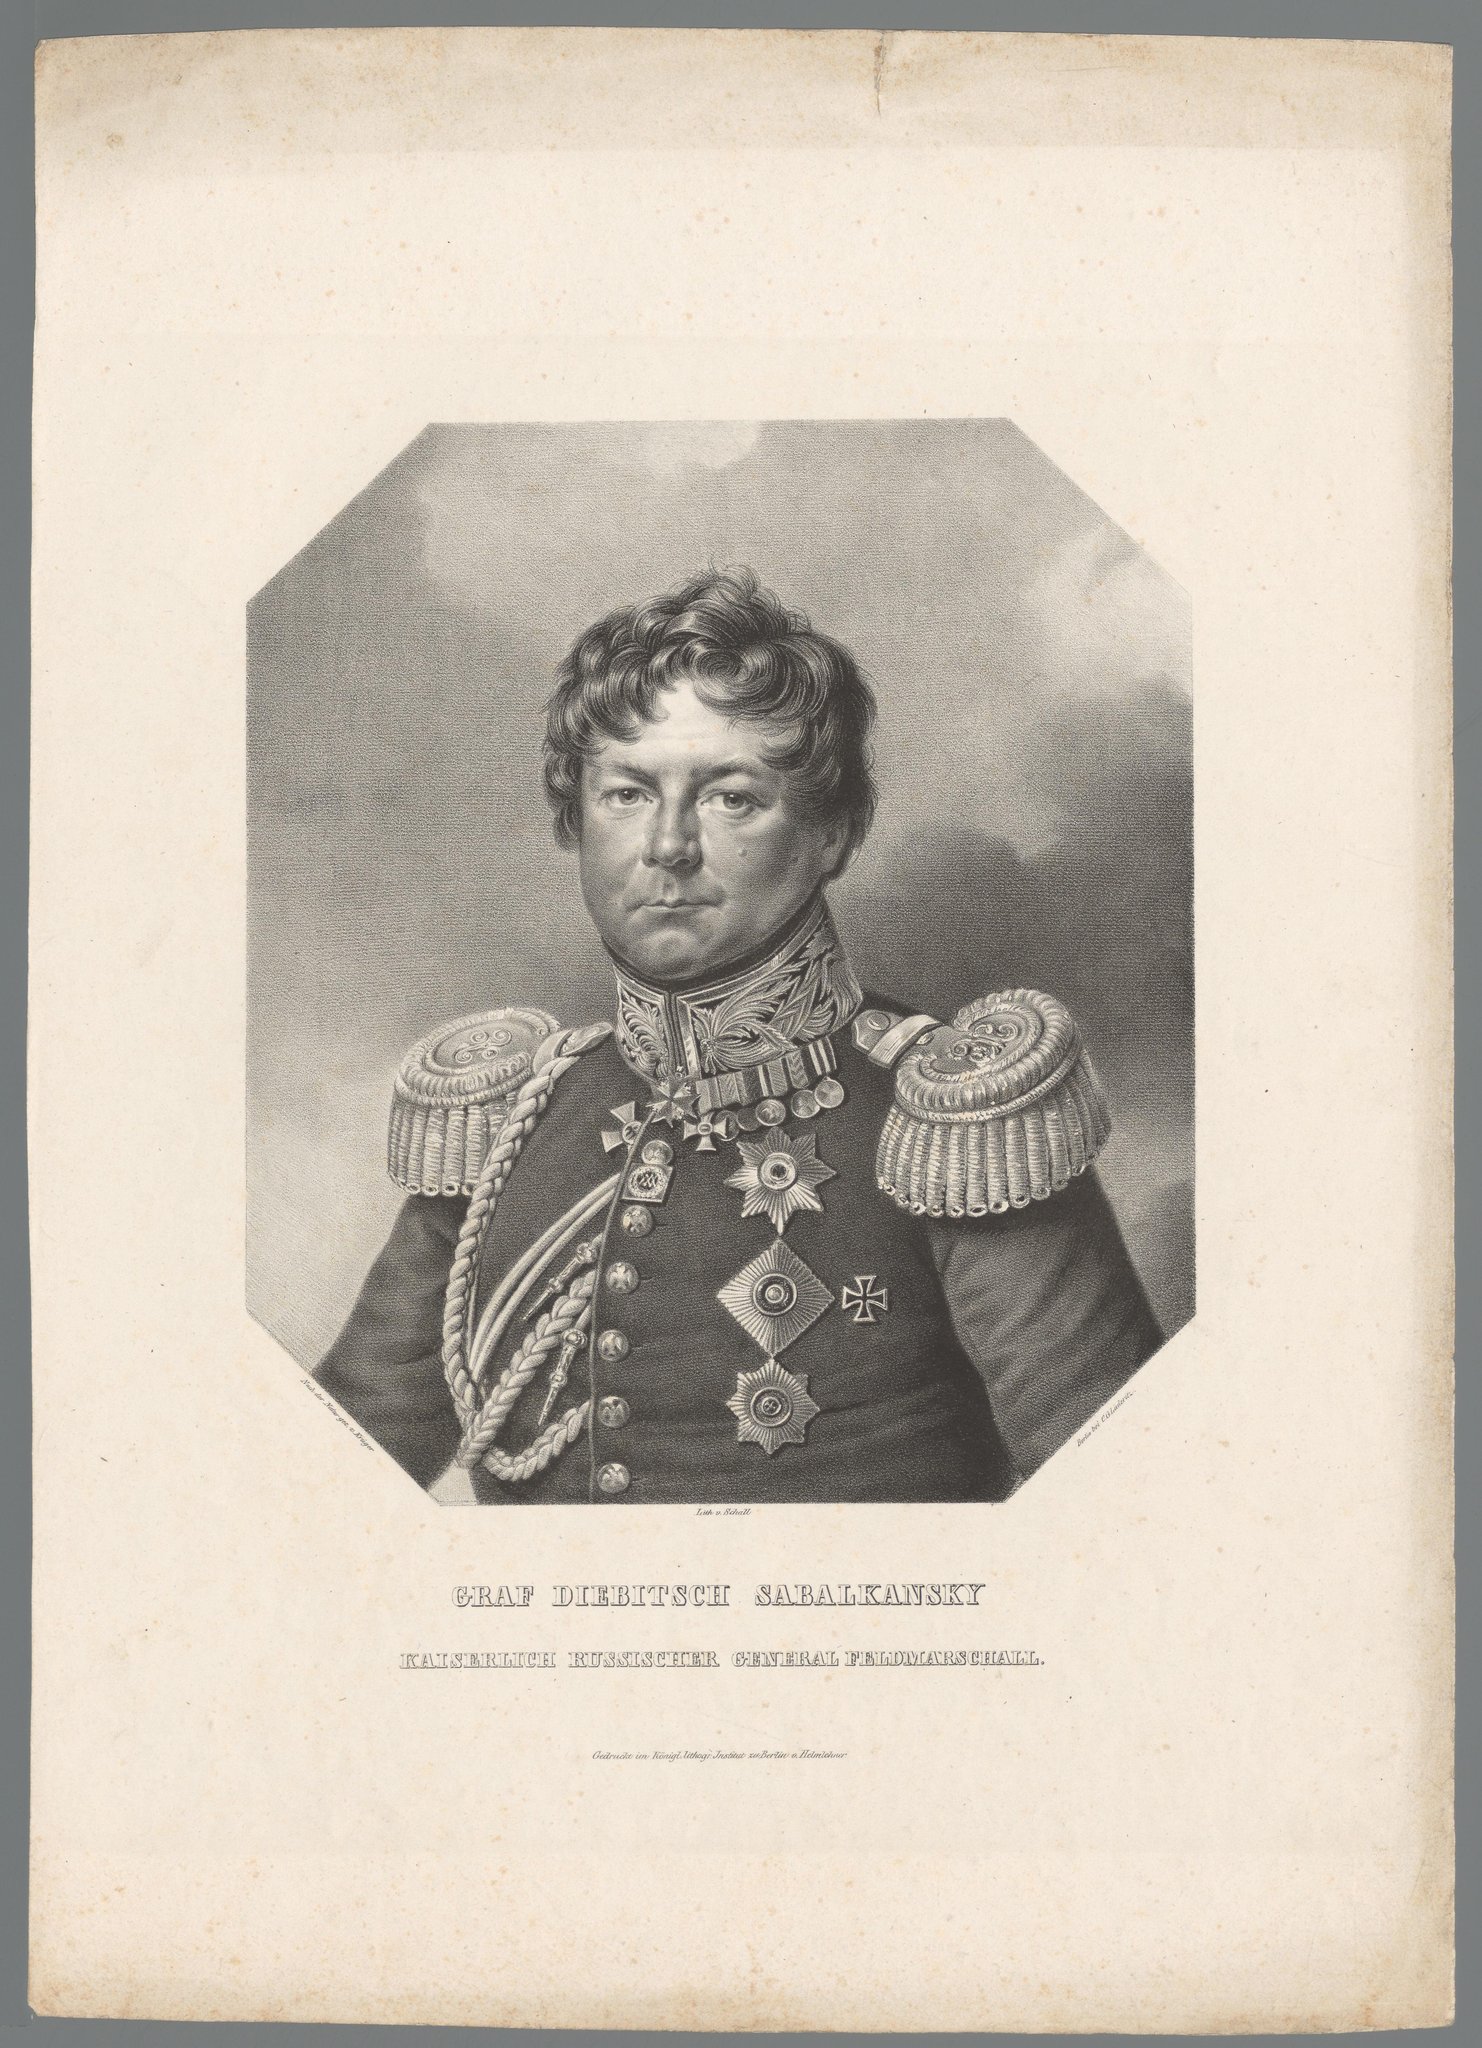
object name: print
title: Graf Diebitsch Sabalkansky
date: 1820-1865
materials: paper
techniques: lithograph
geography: berlin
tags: adult man, historical persons, (military) uniforms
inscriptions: collector's mark: Lugt 2228